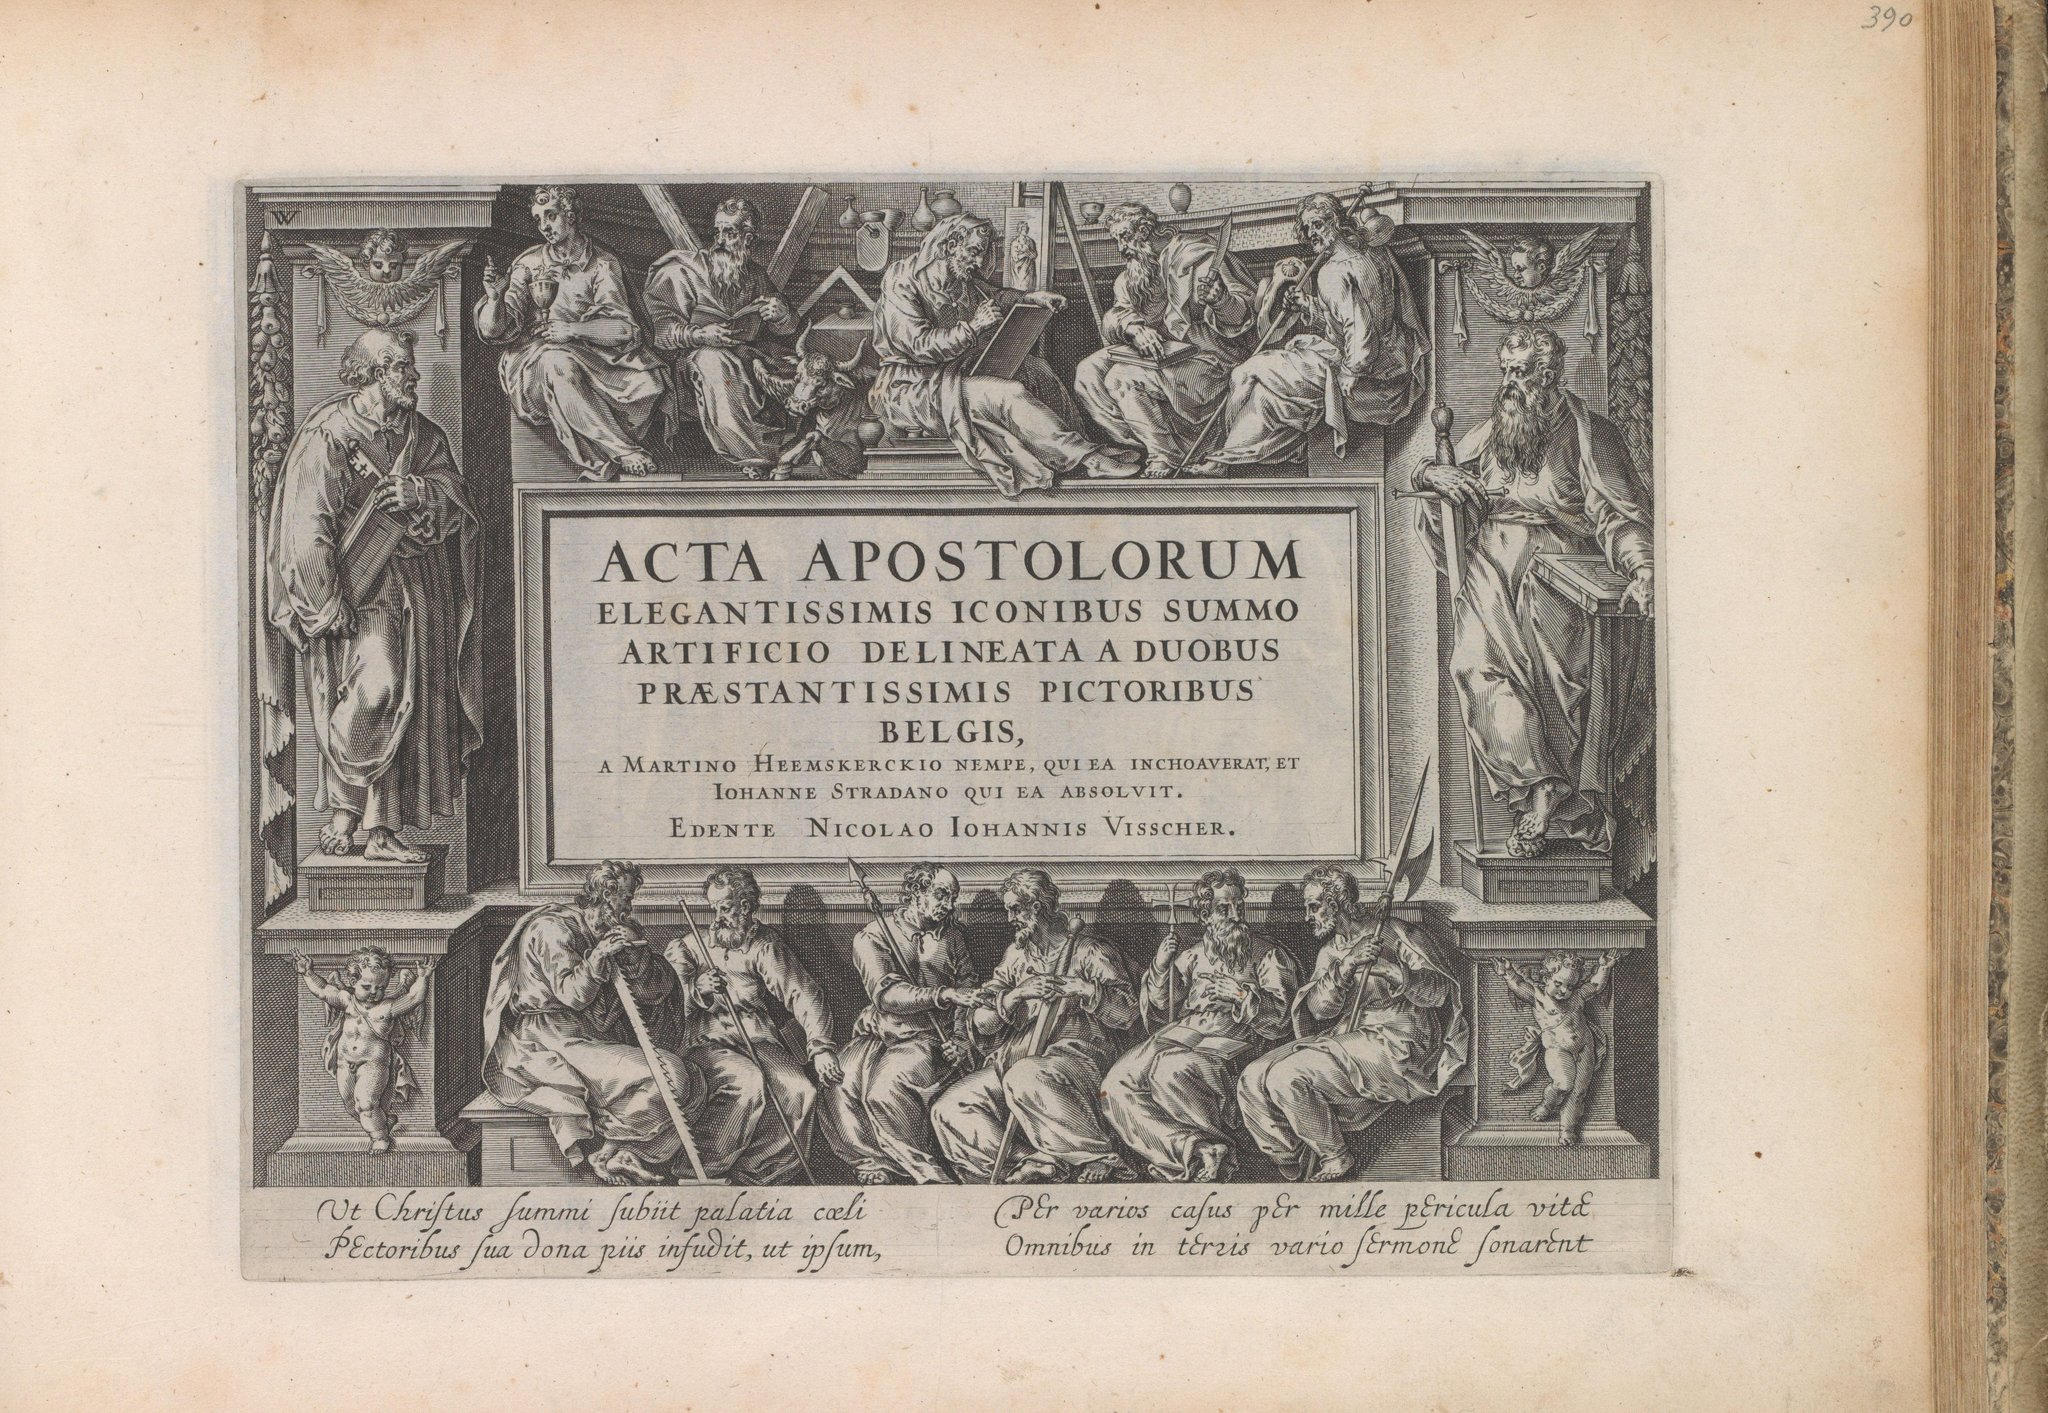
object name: print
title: Acta Apostolorum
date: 1643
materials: paper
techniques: engraving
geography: amsterdam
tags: the twelve apostles (as a group), usually with books or scrolls (not in biblical context), lives and acts of the apostles (part i)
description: Deze prent maakt deel uit van een gekopieerde serie. De originele serie bestaat deels uit prenten van Philips Galle naar ontwerp van Maerten van Heemskerck en deels uit prenten toegeschreven aan Adriaen Collaert naar ontwerp van Johannes Stradanus. Vandaar dat ook de naam van Maerten van Heemskerck wordt genoemd op deze titelprent, hoewel hij voor deze specifieke prent niet het ontwerp maakte.